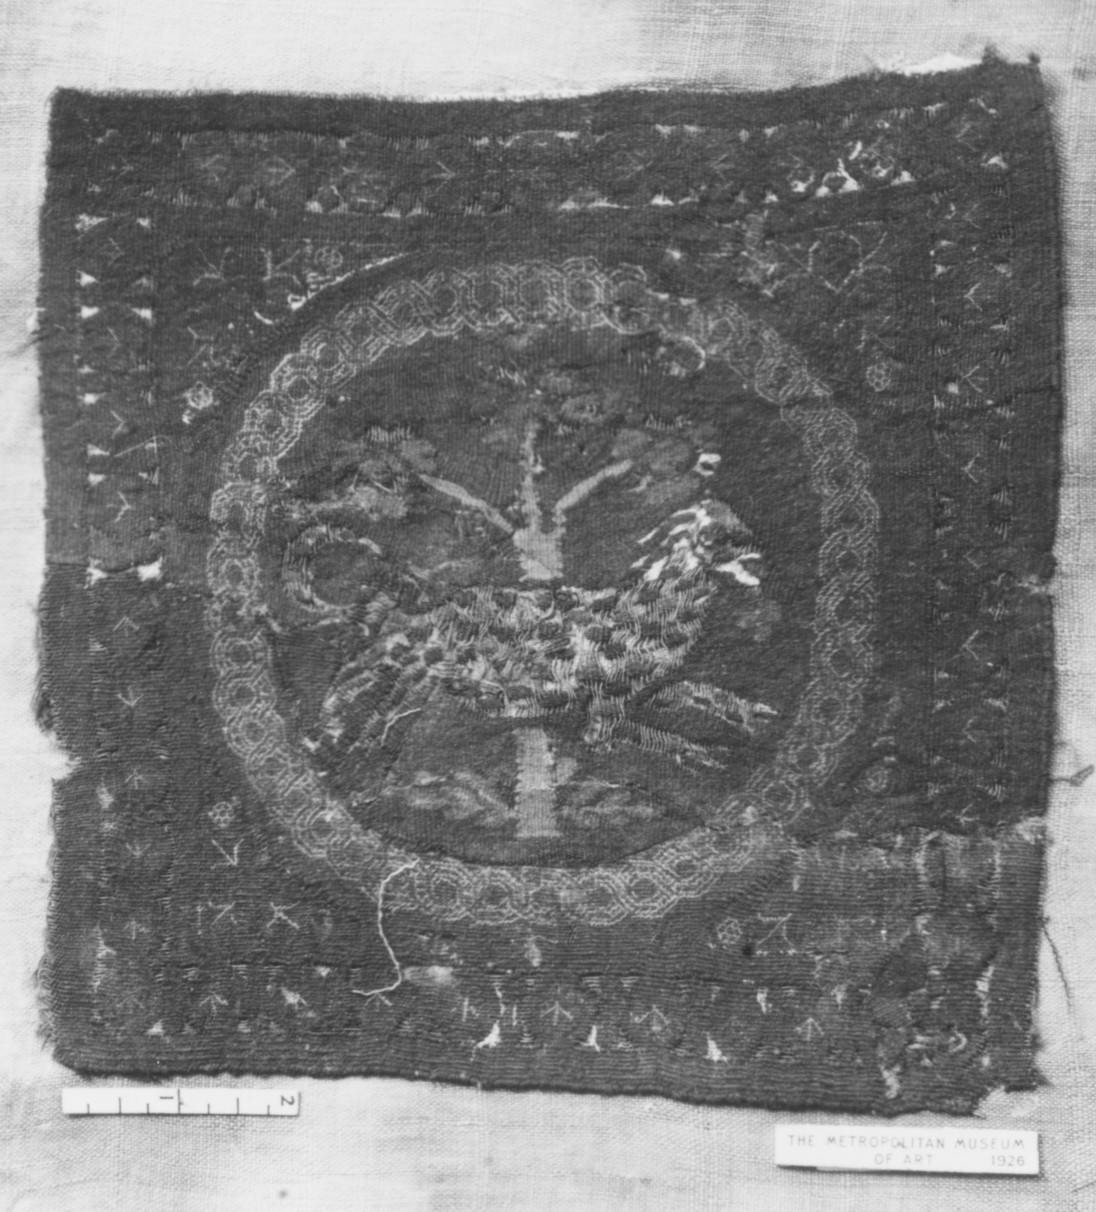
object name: panel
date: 201-400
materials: wool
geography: egypt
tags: animals